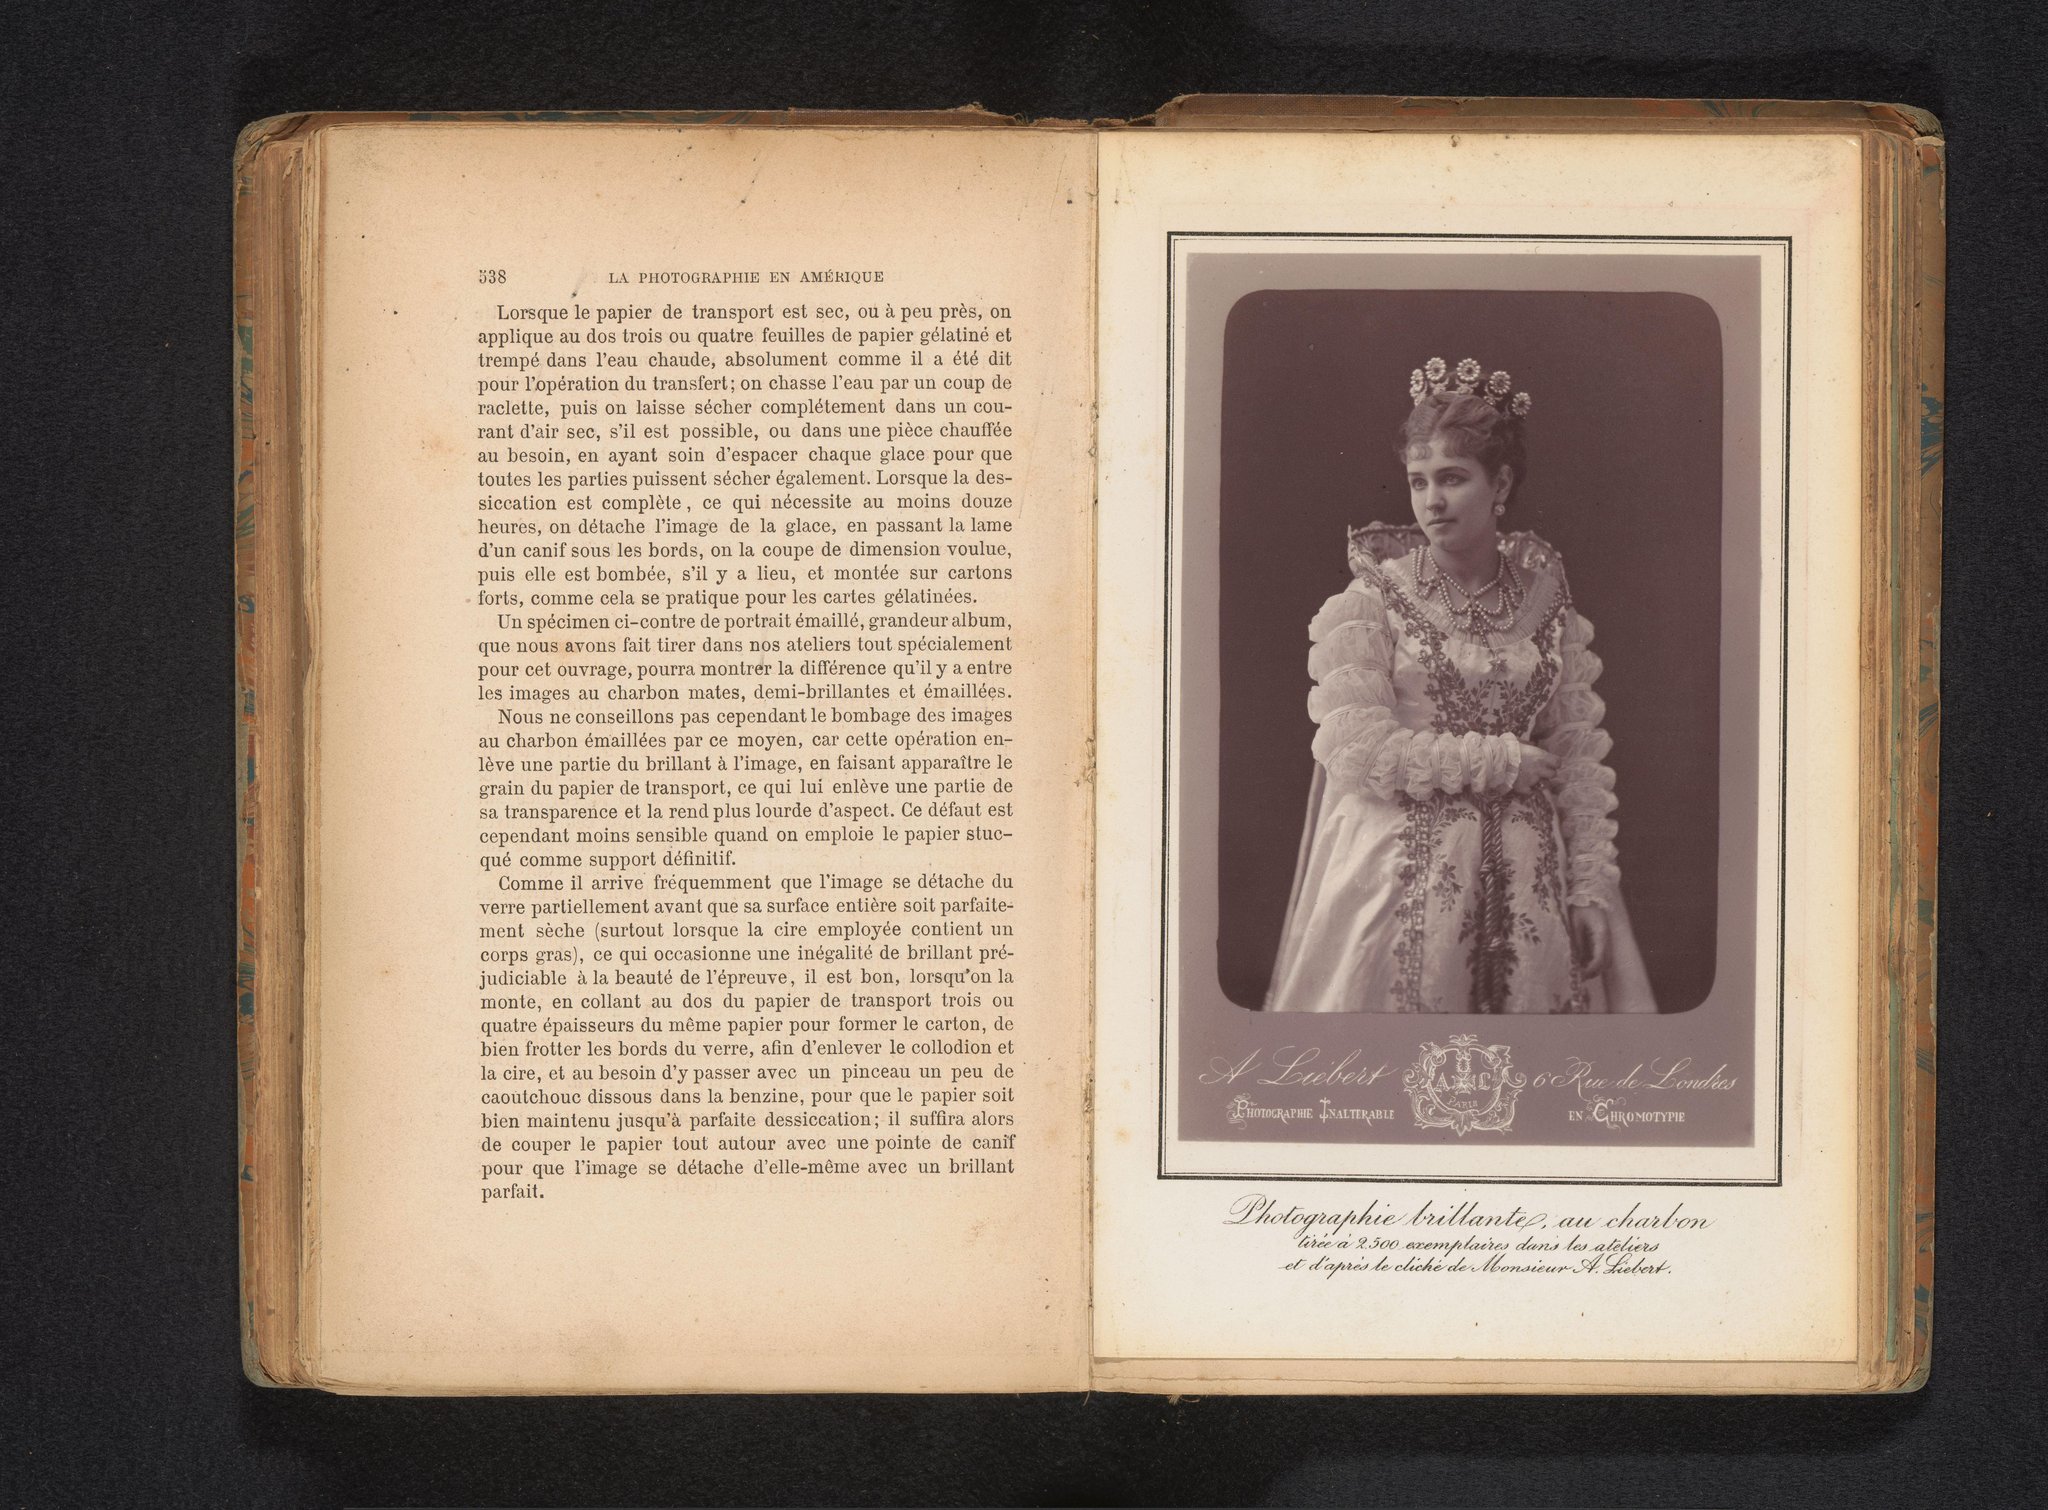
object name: page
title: Belichtingsstudie, afgebeeld een portret van een onbekende vrouw in een gedecoreerde jurk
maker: alphonse-justin liébert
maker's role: fotograaf, marinier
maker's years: 1827-1914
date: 1873-1878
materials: paper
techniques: carbon print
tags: historical persons not known by name - bb - woman, dress, gown: ball gown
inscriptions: inscription: ‘Photographies brillante, au charbon/ tirée à 2.500 exemplaires dans les ateliers/ et d'après le cliché de Monsieur A. Liébert.’, inscription: ‘A. Liébert 6 Rue de Londres/ Paris/ Photographie Inalterable en Chromotypie’